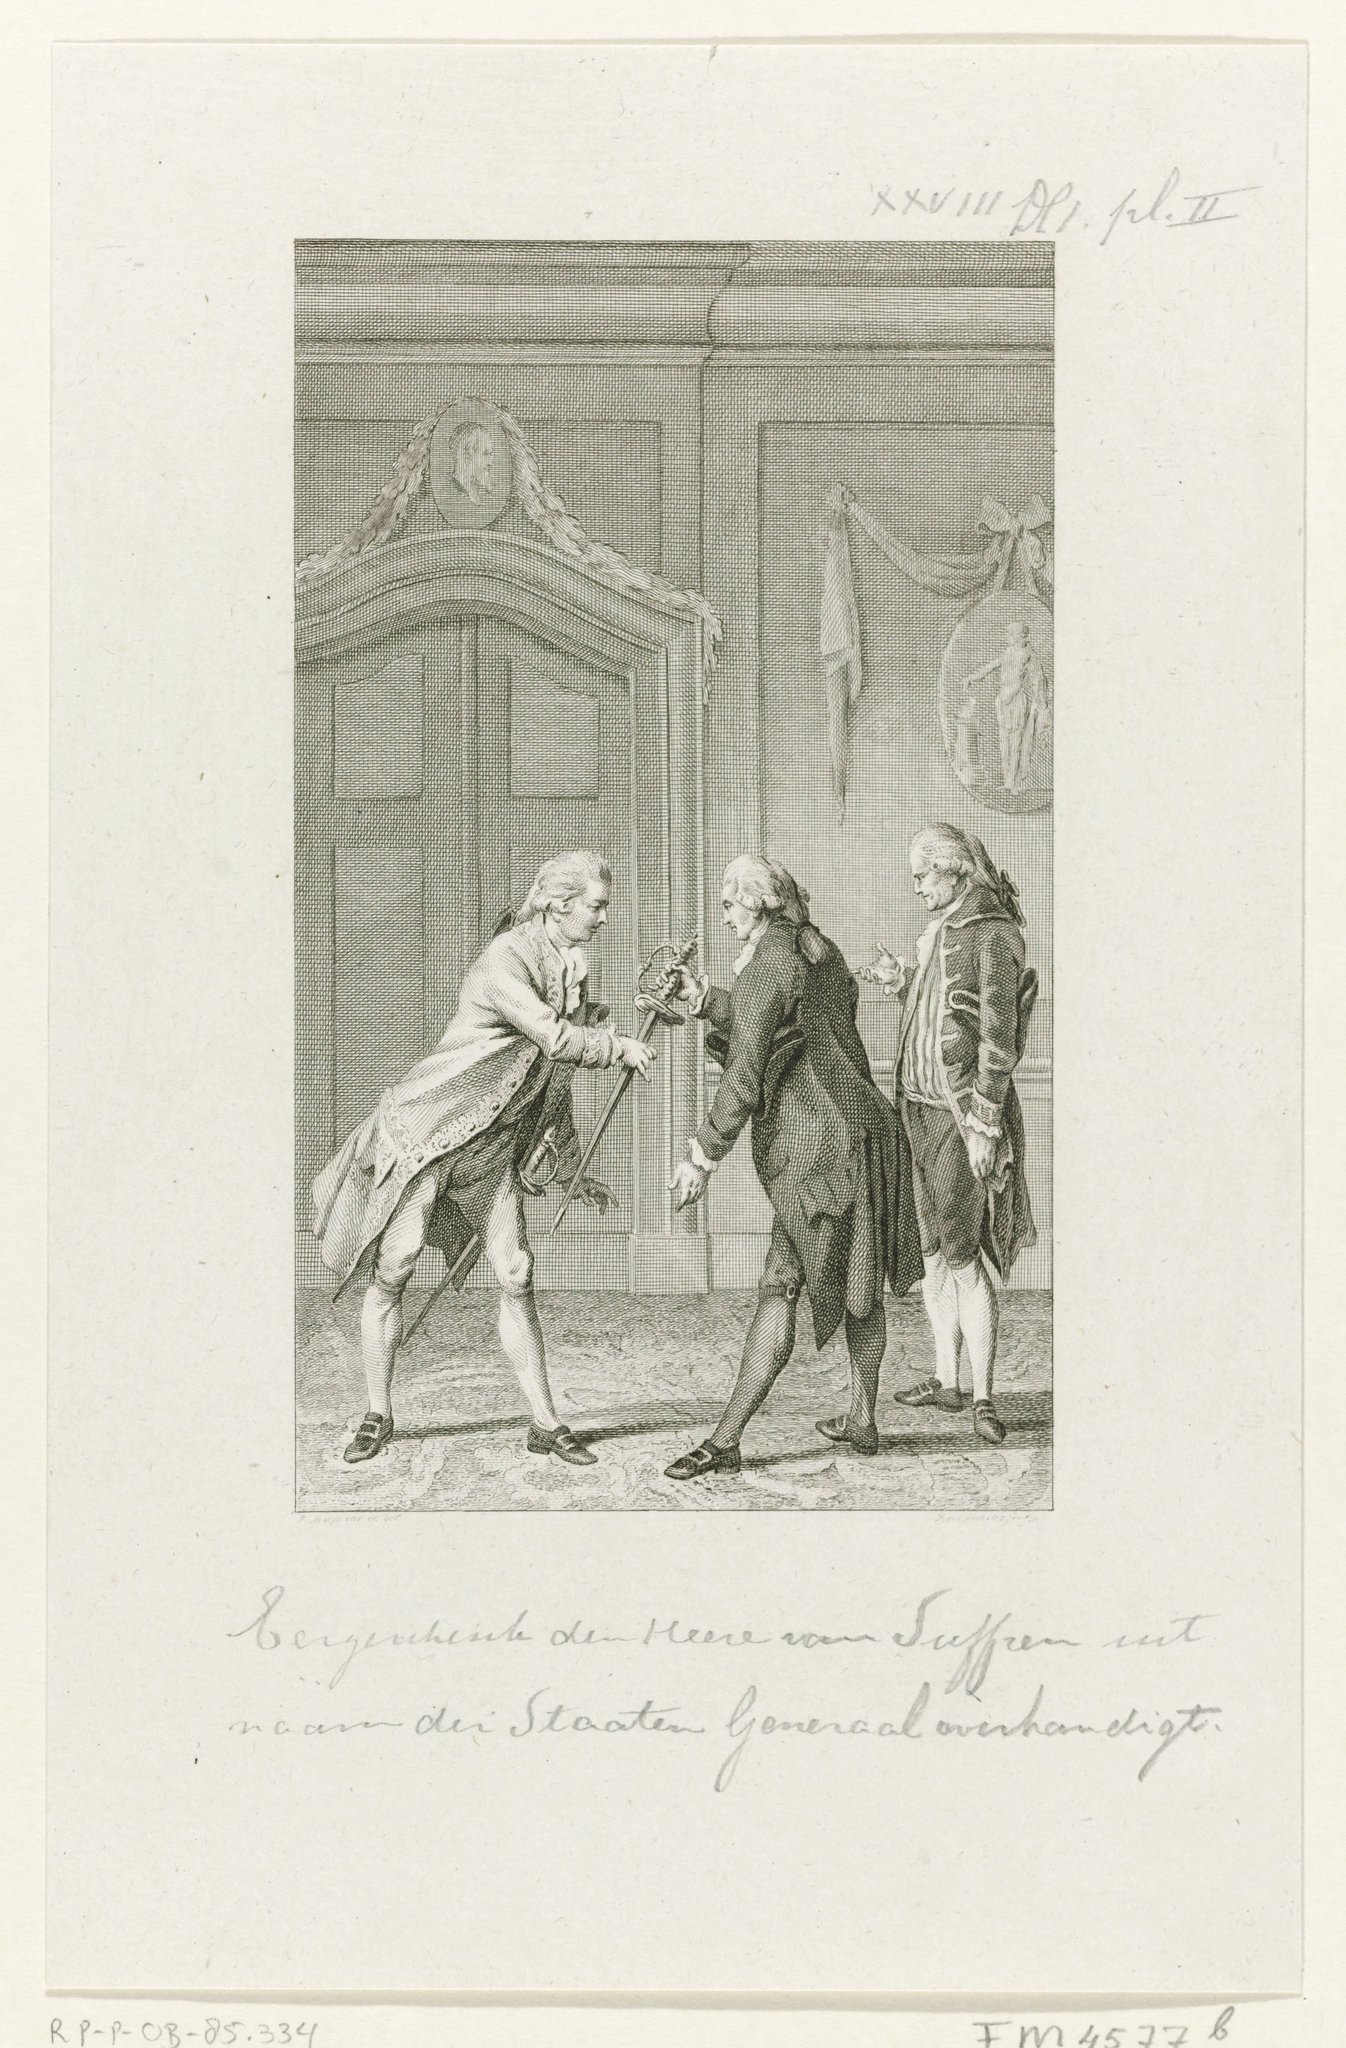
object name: print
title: Geschenk aan admiraal Bailli de Suffren namens de Staten-Generaal, 1784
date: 1792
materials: paper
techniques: engraving, etching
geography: northern netherlands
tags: paris, gifts being accepted, presentation of sword ~ installation of a ruler, fourth anglo-dutch war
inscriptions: collector's mark: Lugt 2228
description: Presentatie van het geschenk van een gouden degen aan de Franse admiraal Pierre André de Suffren de Saint-Tropez, wegens zijn verdiensten in de strijd tegen de Engelsen in Oost-Indië, 1784. De degen wordt overhandigd namens de Staten-Generaal door G. Brantsen en l'Estévenon van Berkenrode.